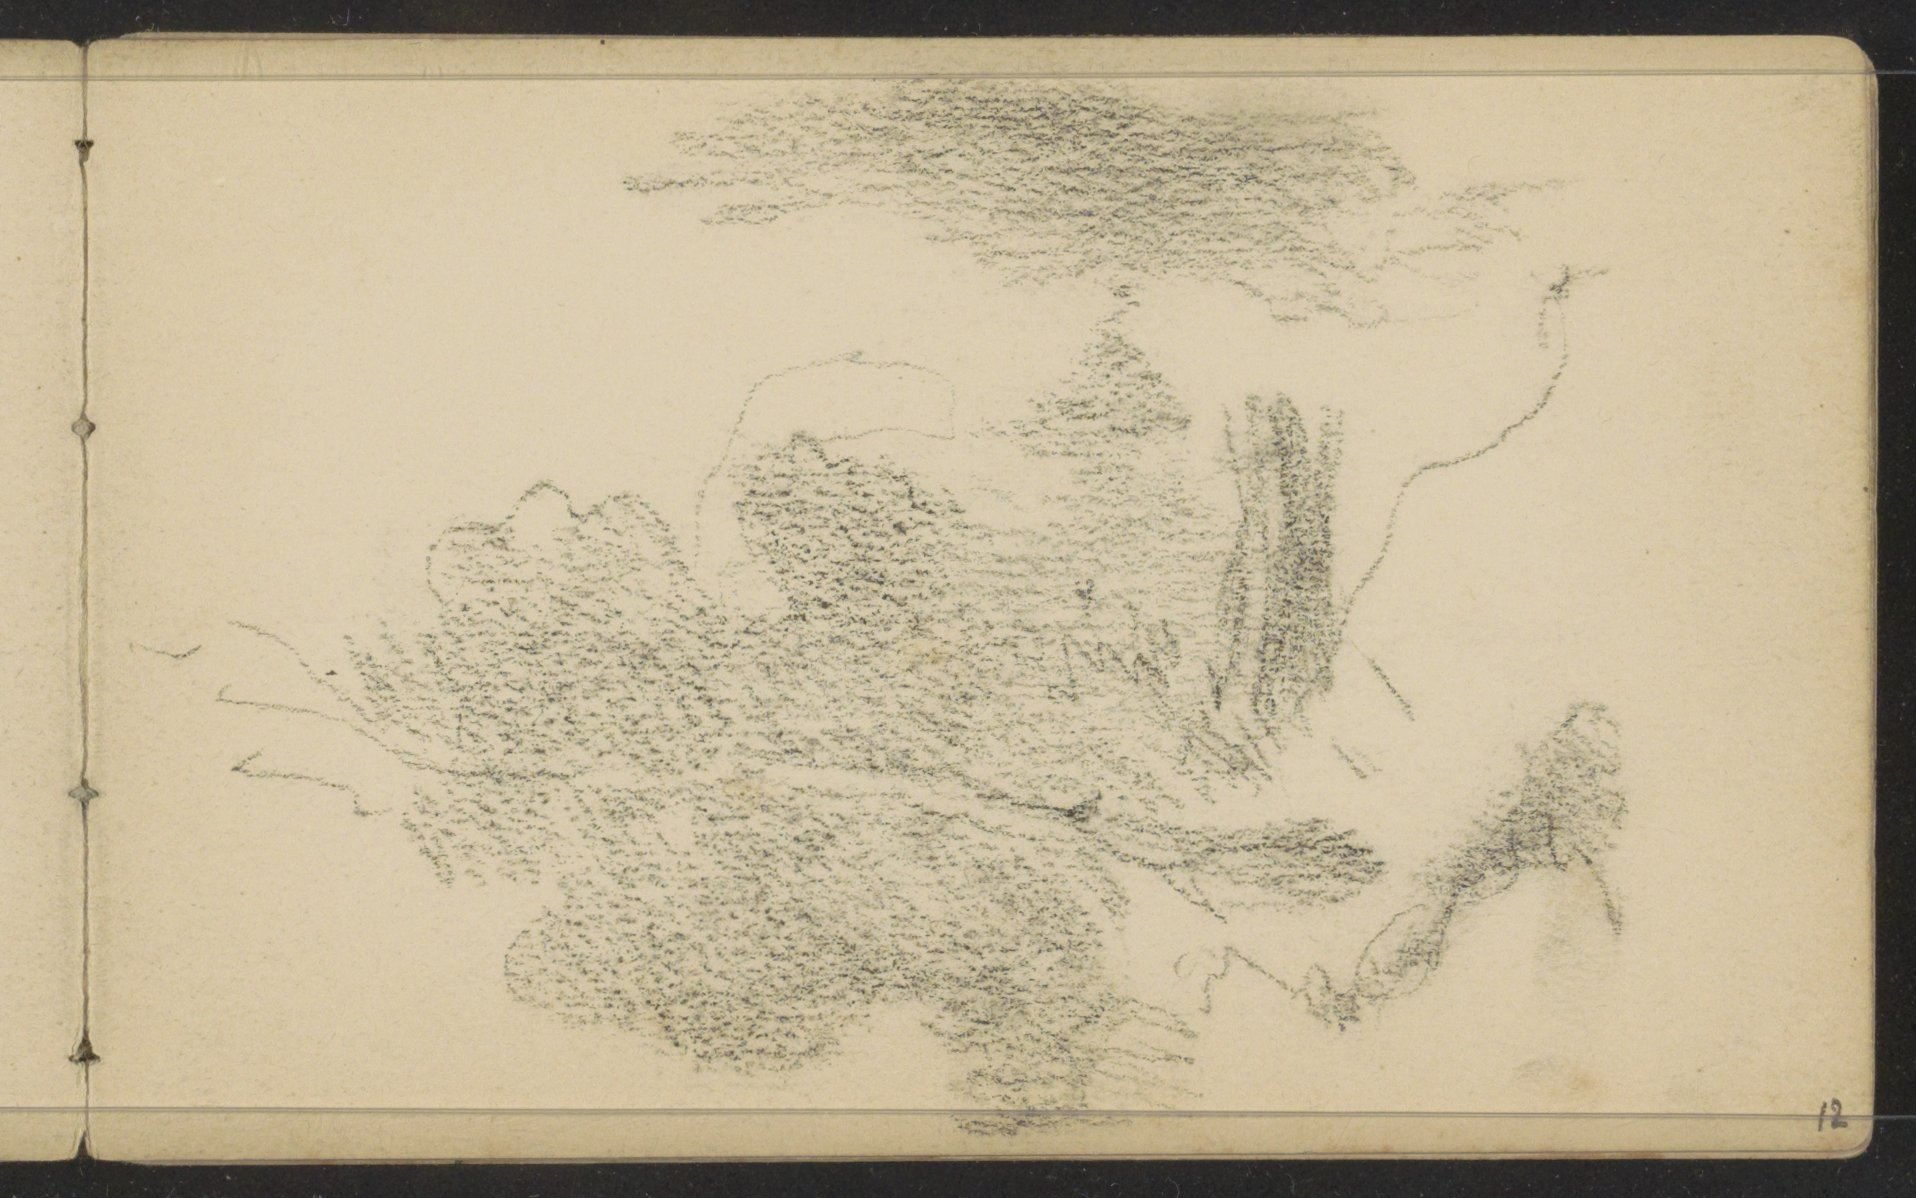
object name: sketchbook leaf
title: Boom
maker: willem cornelis rip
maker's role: draughtsman, painter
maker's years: 1856-1922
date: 1892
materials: chalk, paper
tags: trees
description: Blad 12 recto uit een schetsboek met 25 bladen.